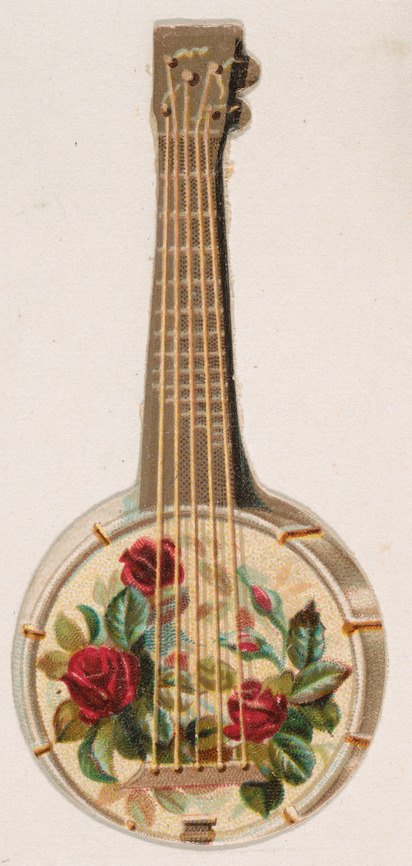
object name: print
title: Banjo, from the Novelties series (N228, Type 3) issued by Kinney Bros.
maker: kinney brothers tobacco company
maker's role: publisher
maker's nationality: american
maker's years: 1869-2011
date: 1889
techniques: color lithograph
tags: musical instruments